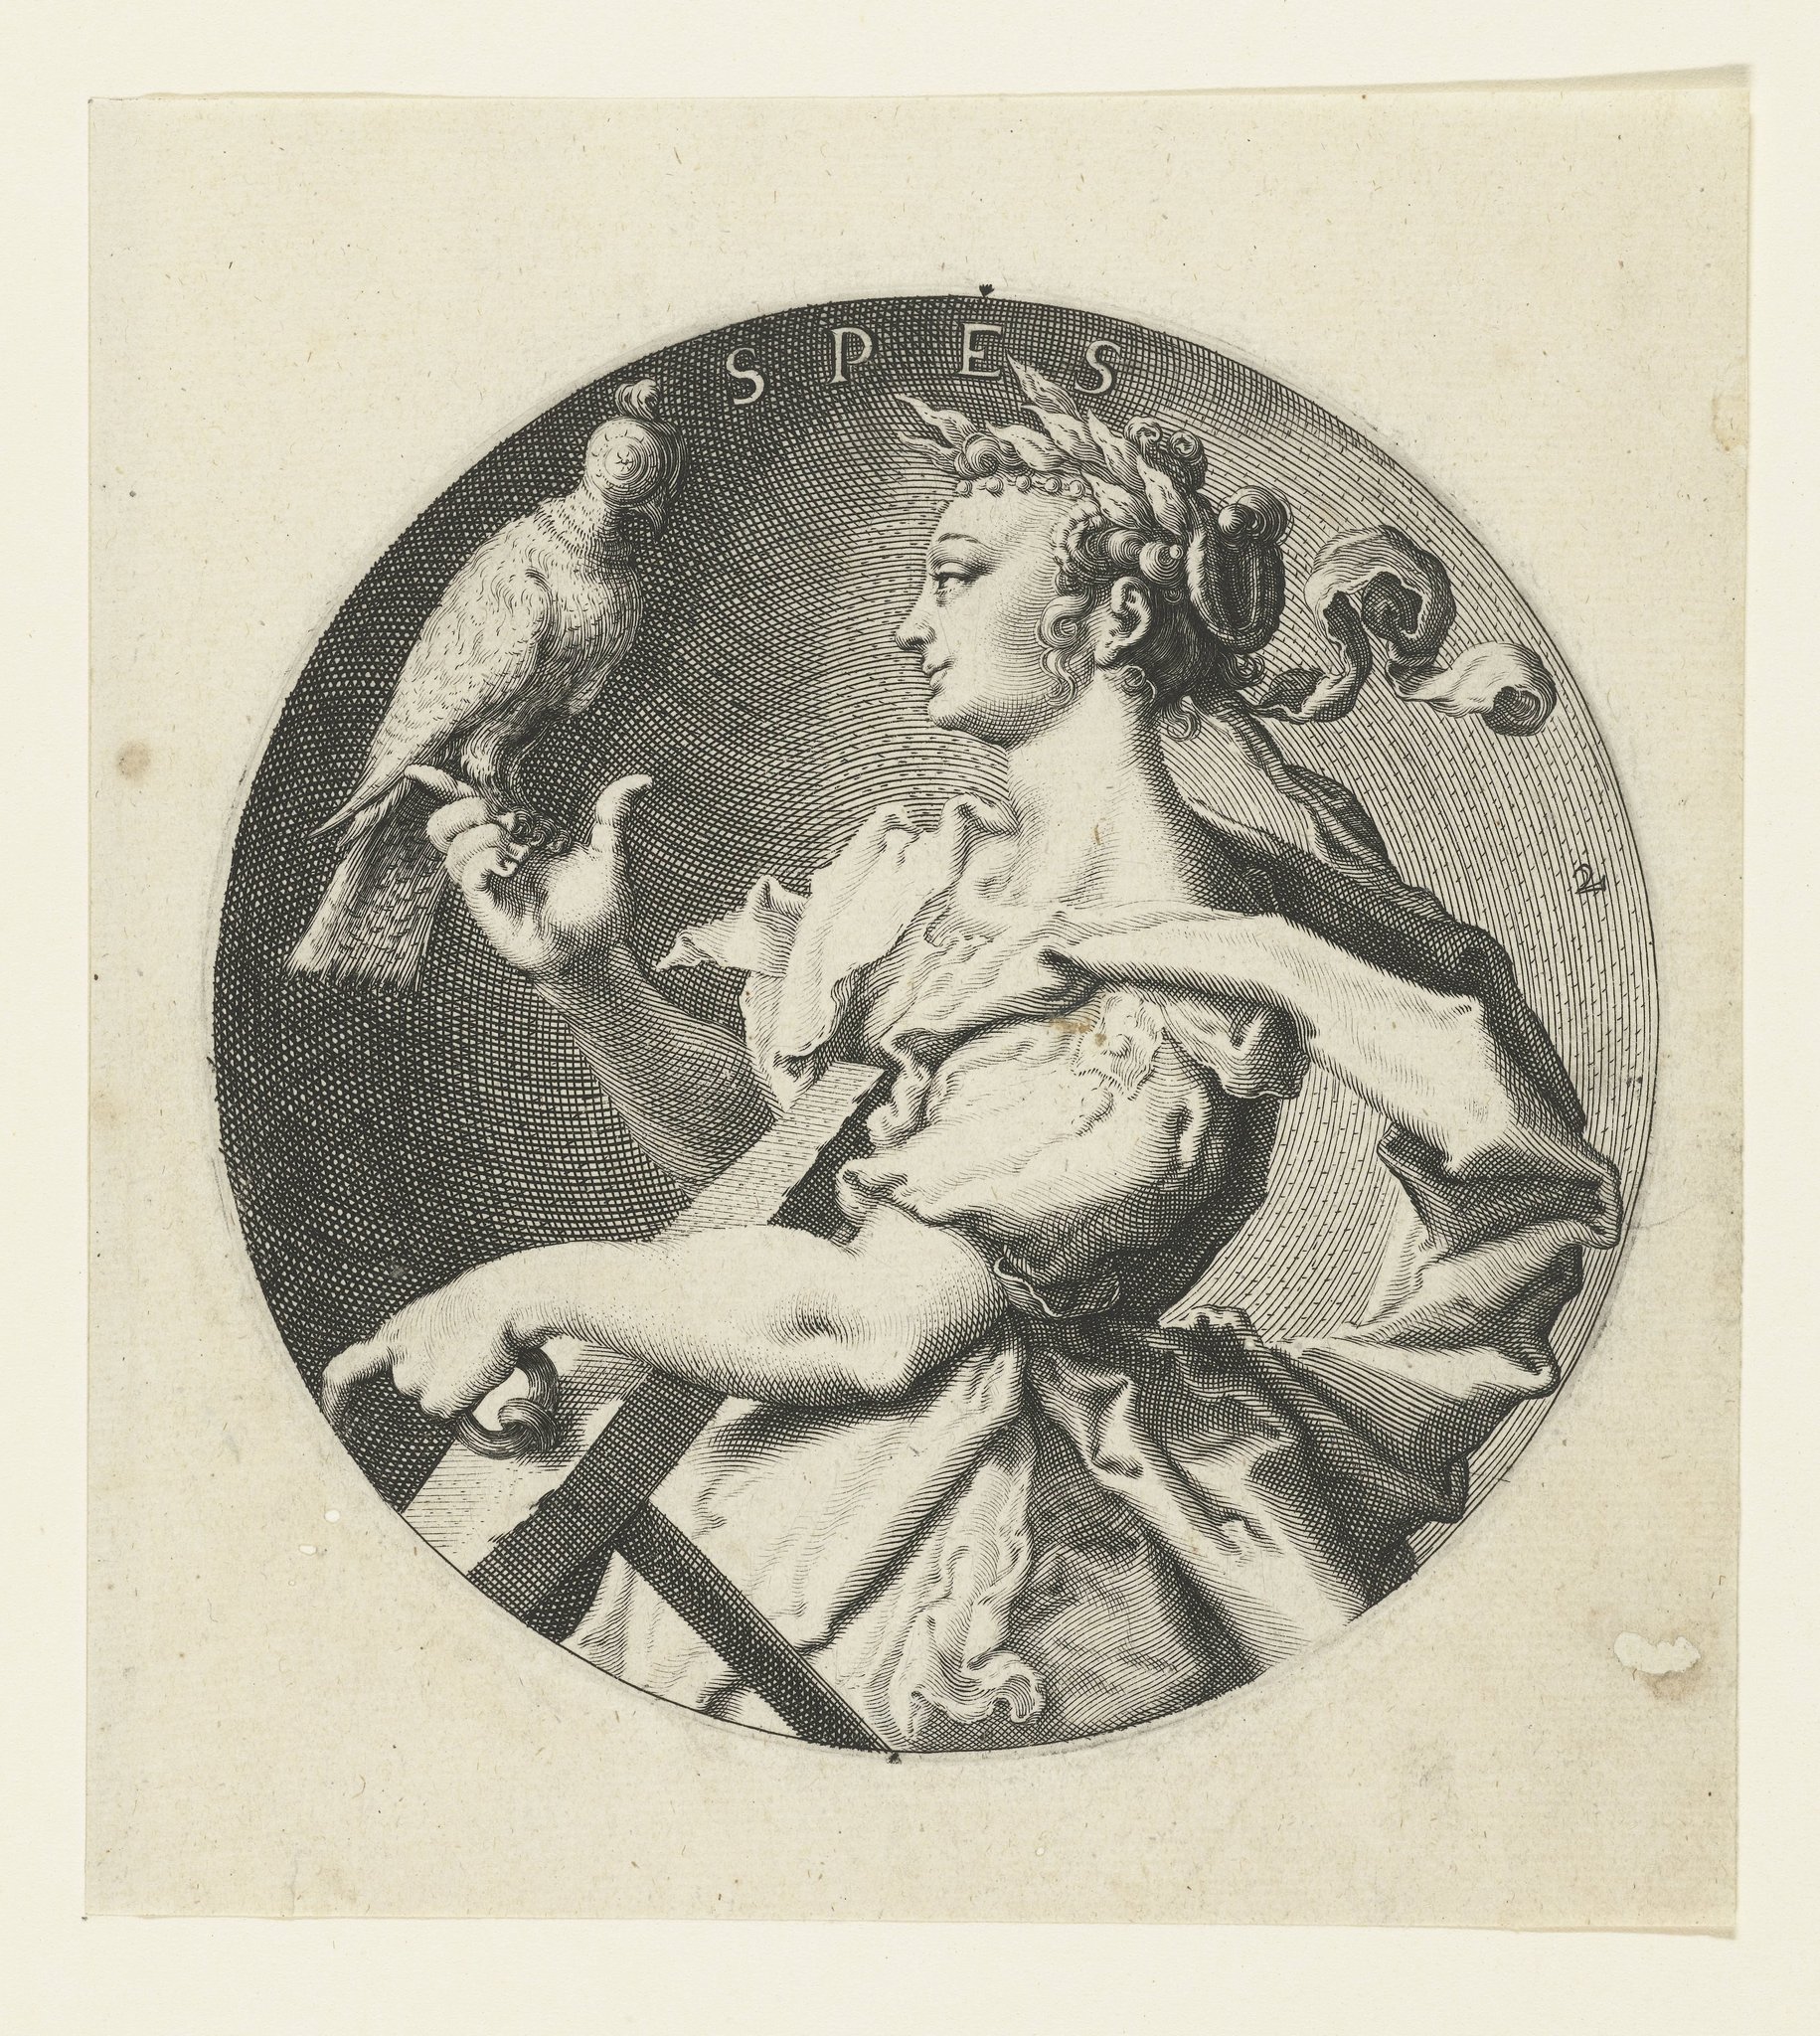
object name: print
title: Hoop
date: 1591-1595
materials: paper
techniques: engraving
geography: netherlands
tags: hope, 'spes'; 'speranza divina e certa' (ripa) ~ one of the three theological virtues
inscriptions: collector's mark: Lugt 2228a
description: Hoop, in de gedaante van een vrouw met een anker in de linkerhand en een roofvogel op de rechterhand. Bovenin de voorstelling het woord 'SPES' (hoop). Deze prent is onderdeel van een serie van zeven ronde voorstellingen van de deugden, elk gepersonifieerd door een vrouwenfiguur met typerende attributen, en met Latijns opschrift.